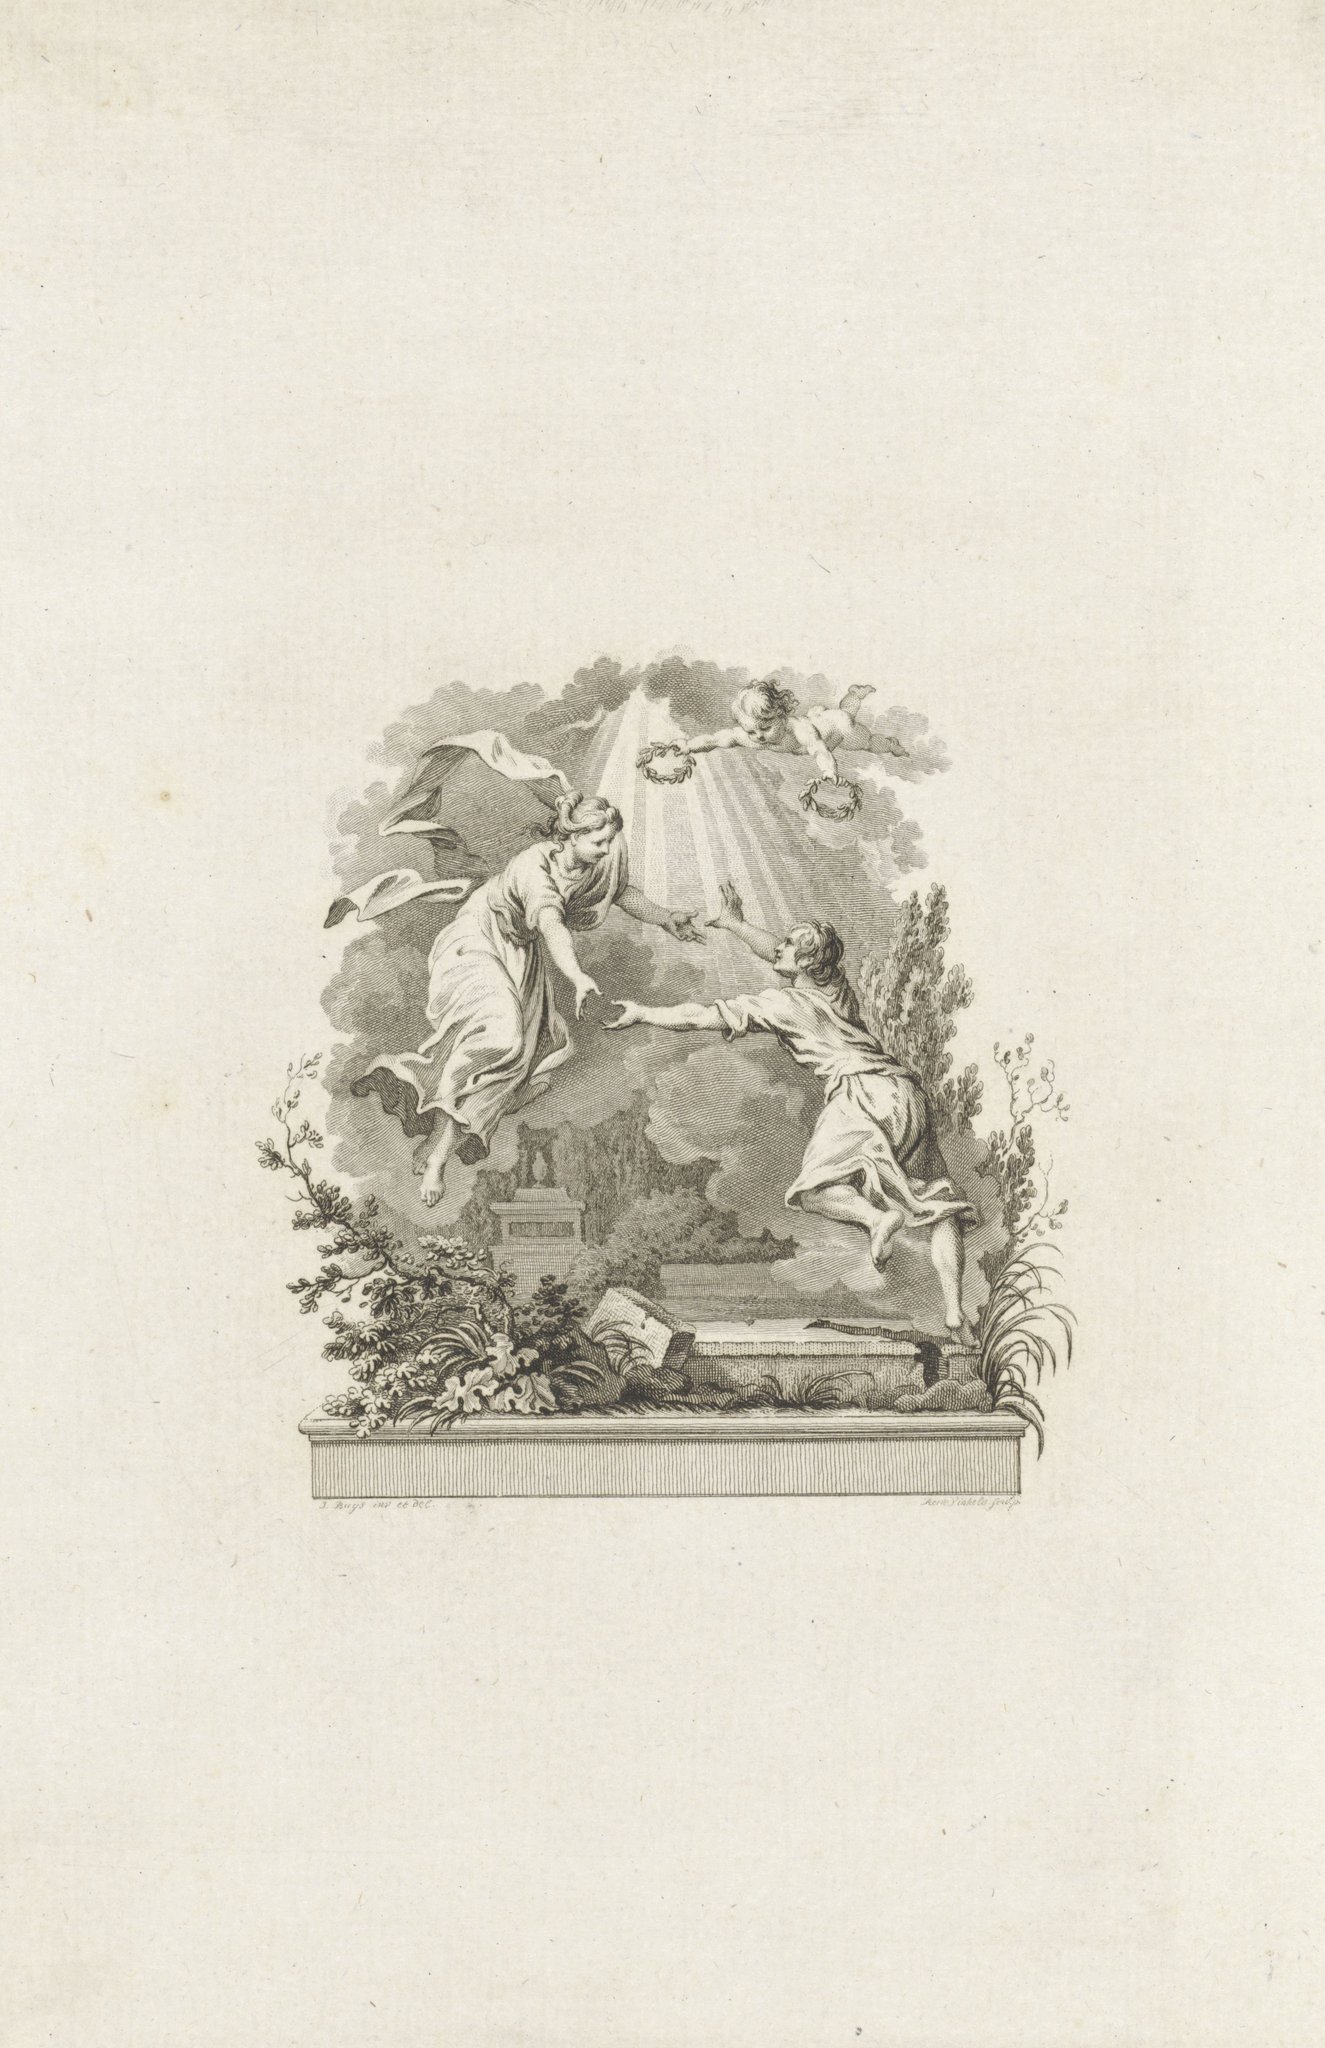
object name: print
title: Paar herenigd na de dood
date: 1751-1816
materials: paper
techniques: engraving, etching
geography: amsterdam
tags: trees: laurel, lovers' meeting, cupids: 'amores', 'amoretti', 'putti'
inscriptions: collector's mark: Lugt 240